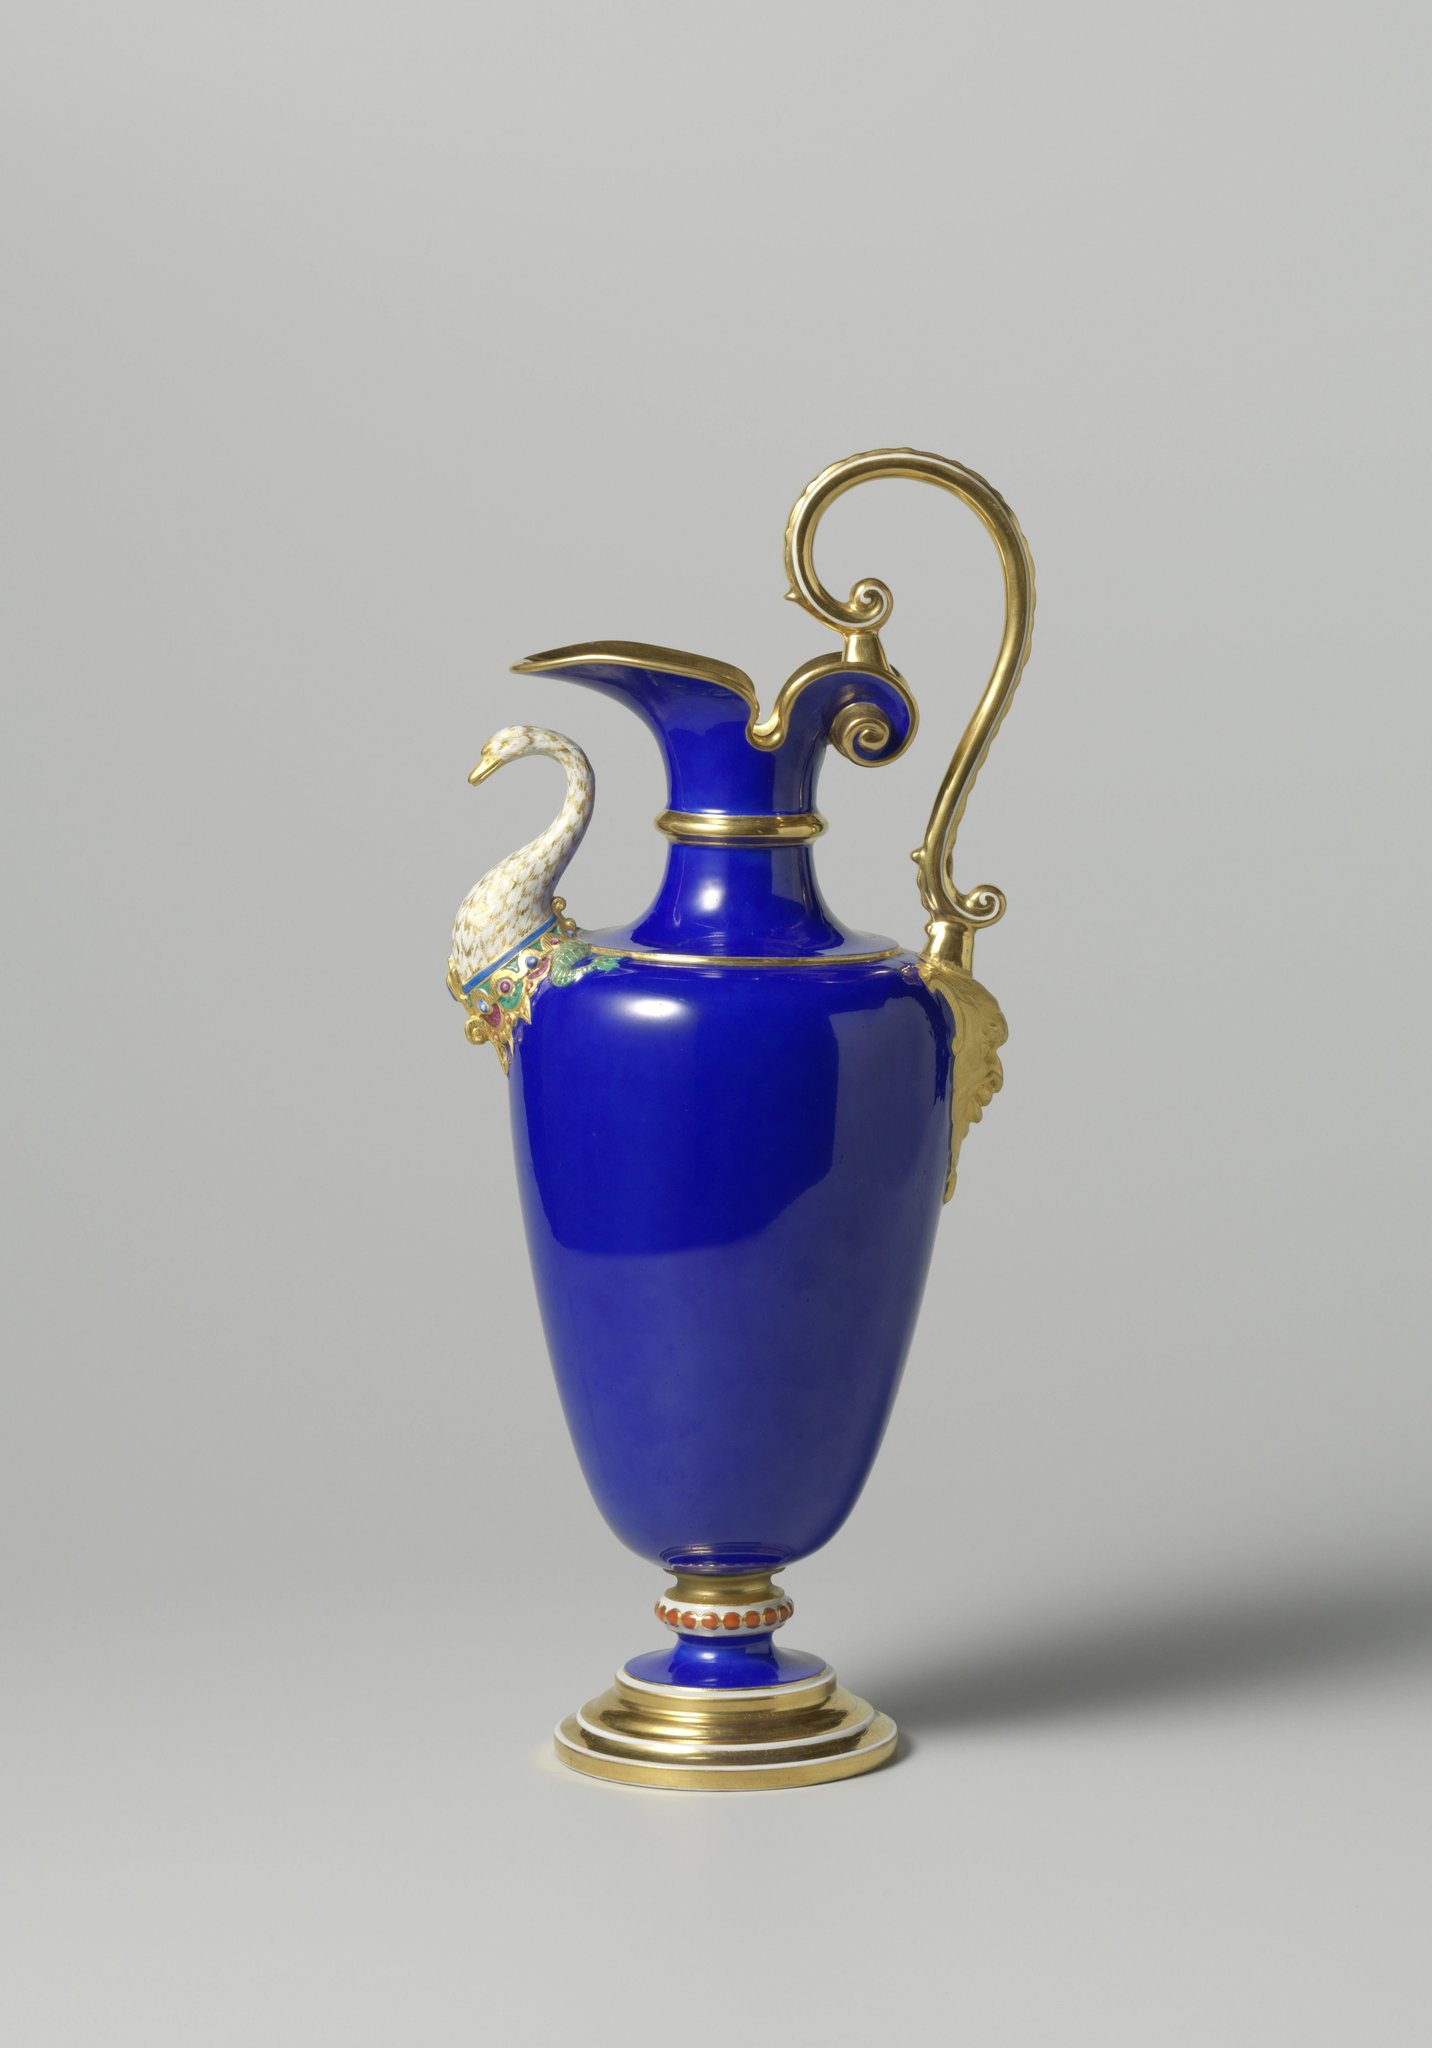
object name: ewer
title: Ewer with a swan's neck and a mask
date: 1850-1870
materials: glaze, gold, porcelain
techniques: firing, forming, gilding, turning, vitrification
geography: berlin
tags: ornament derived from animal forms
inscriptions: mark: ‘adelaar in medaillon en KOENIGL. PORZELLAN MANUFAKTUR/ rode rijksappel met K.P.M’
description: Sierkan van porselein op een hoge zich in vertredingen sterk verjongende voet met een nodus (met bout vastgeschroefd aan het lichaam), met een eivormig lichaam en een sterk verjongende schouder met een door een profilering ingesnoerde hals en een trompetvormige opening die aan de ene zijde een sterk naar buiten springende lip heeft en aan de andere zijde in een rol eindigt waarop het S-vormige oor is bevestigd. Onder de schenklip is in een quasi-montering van goud en edelstenen een zwanehals gemonteerd. Aan de achterzijde is het oor boven een masker vastgezet. Voet, masker, oor en binnenzijde verguld, het lichaam met een lapis-lazuli fond, de zwanehals en de montering veelkleurig. Gemerkt: Rijksappel en KPM in rood op de glazuur; zogenaamd Pfennig merk (adelaar in cirkel waaromheen tekst) in blauw onderglazuur.